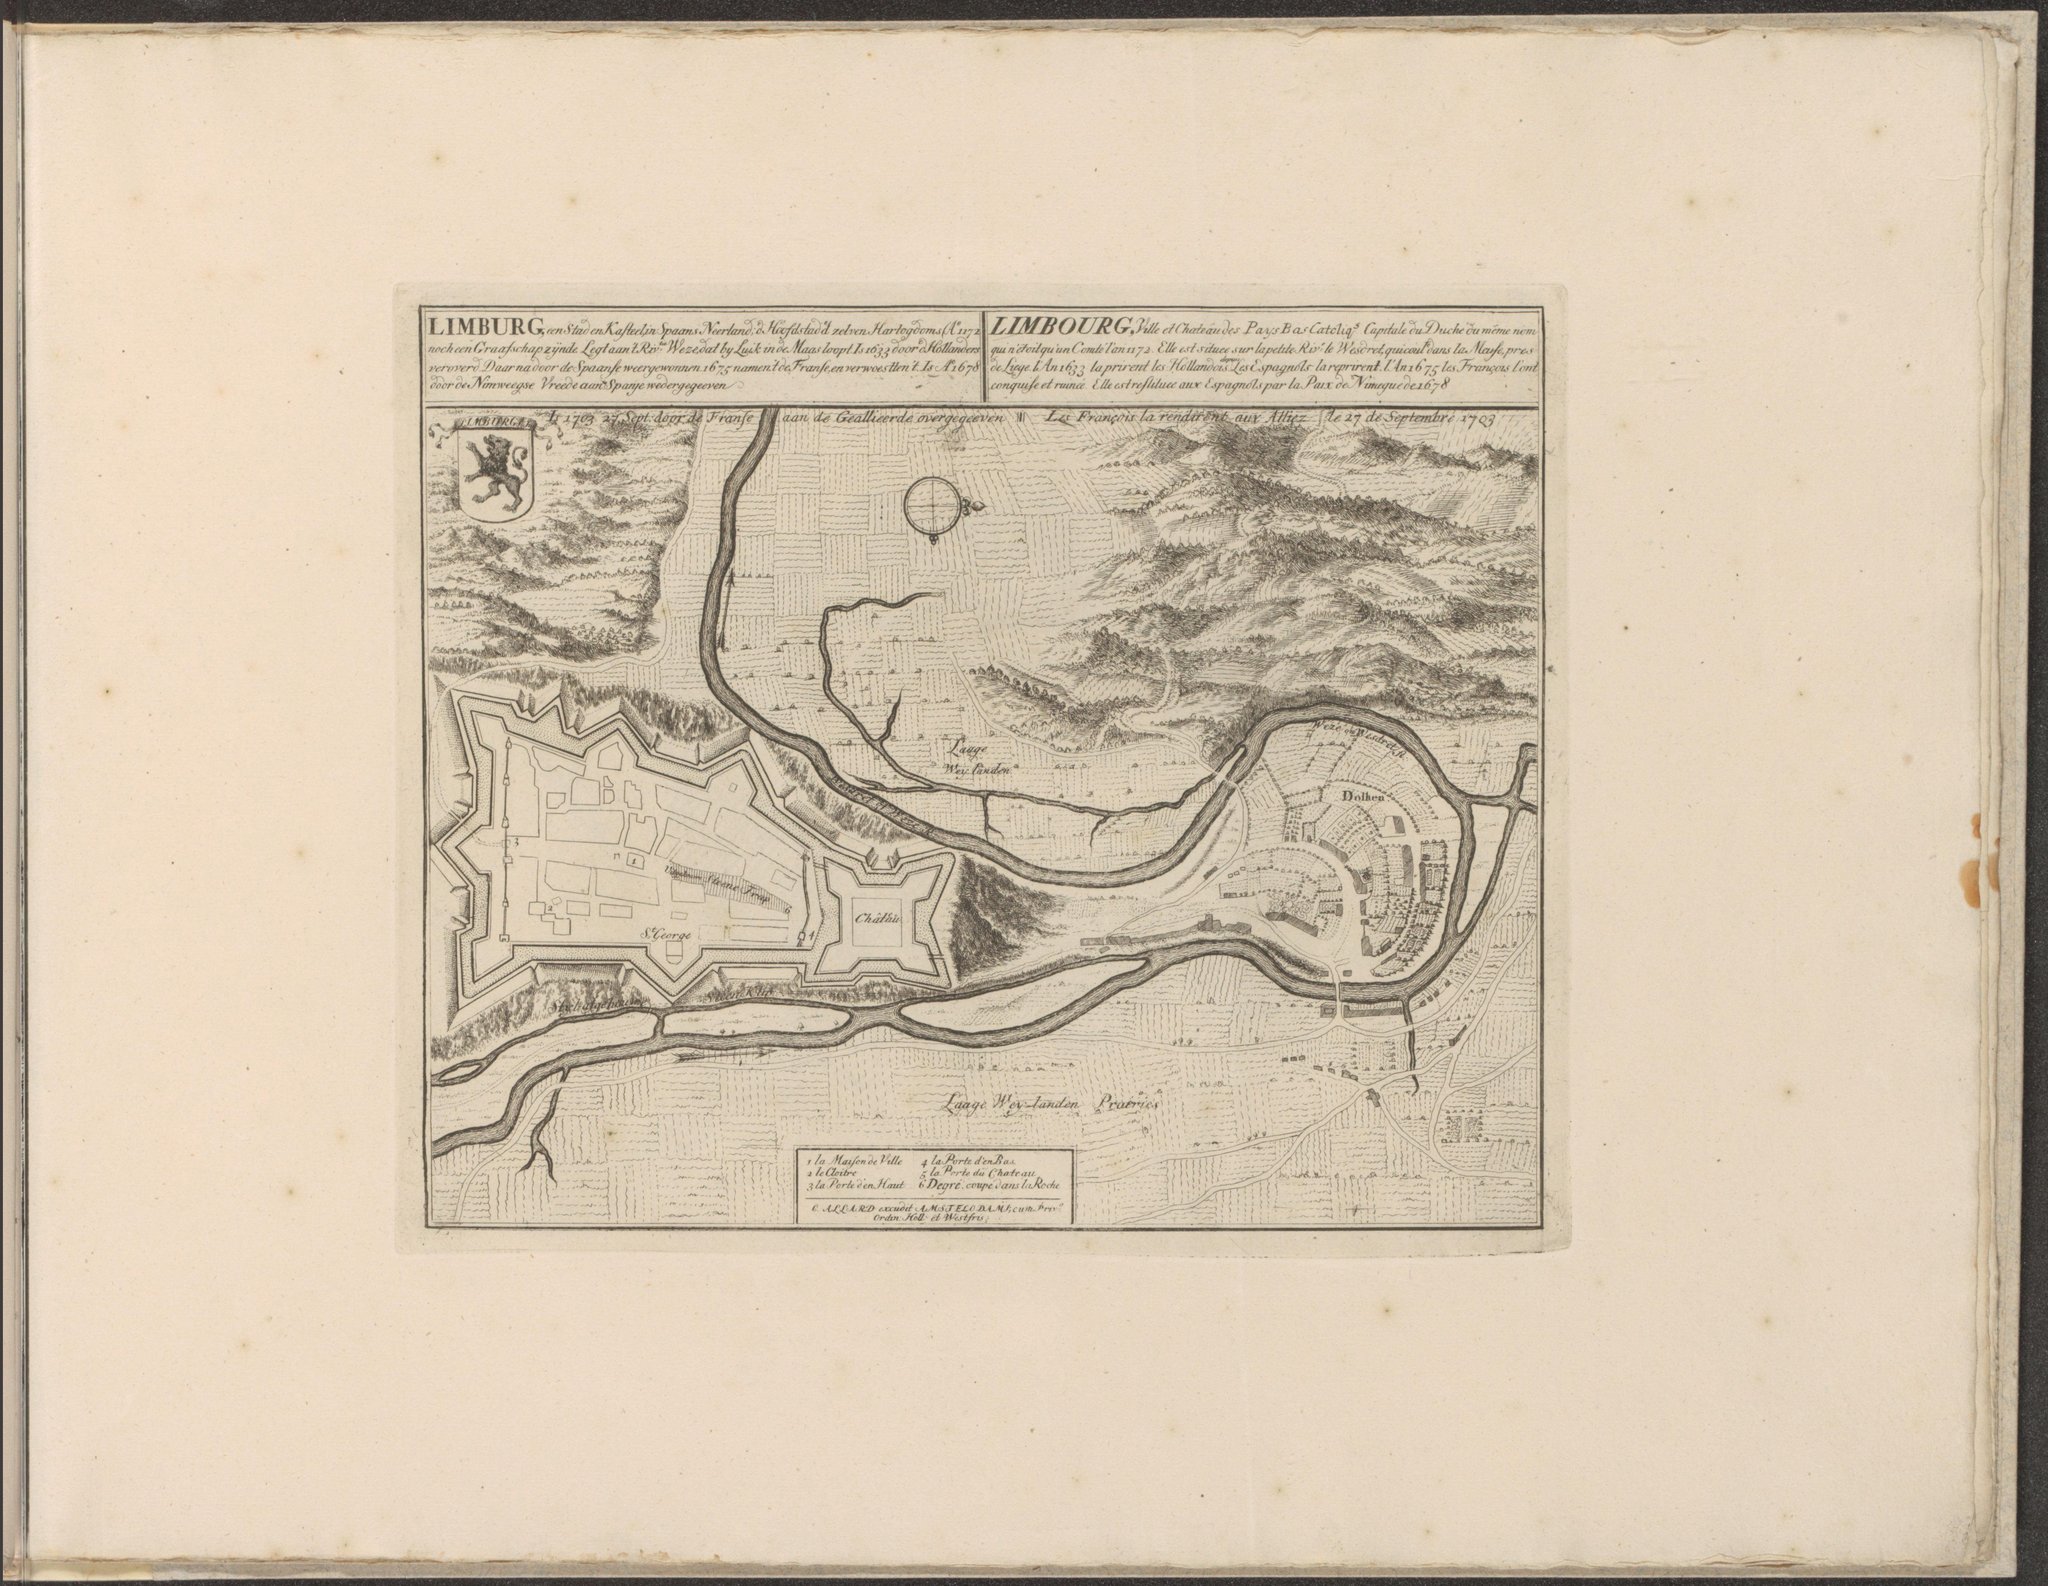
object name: album leaf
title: Plattegrond van Limburg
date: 1703-1733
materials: paper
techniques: etching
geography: leiden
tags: fortifications, military engineering, maps of cities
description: Plattegrond van de stad Limburg (Limbourg) in de Spaanse Nederlanden, veroverd door de geallieerden op de Fransen, 27 september 1703. Met teksten in het Nederlands en Frans. De prent maakt deel uit van een album.